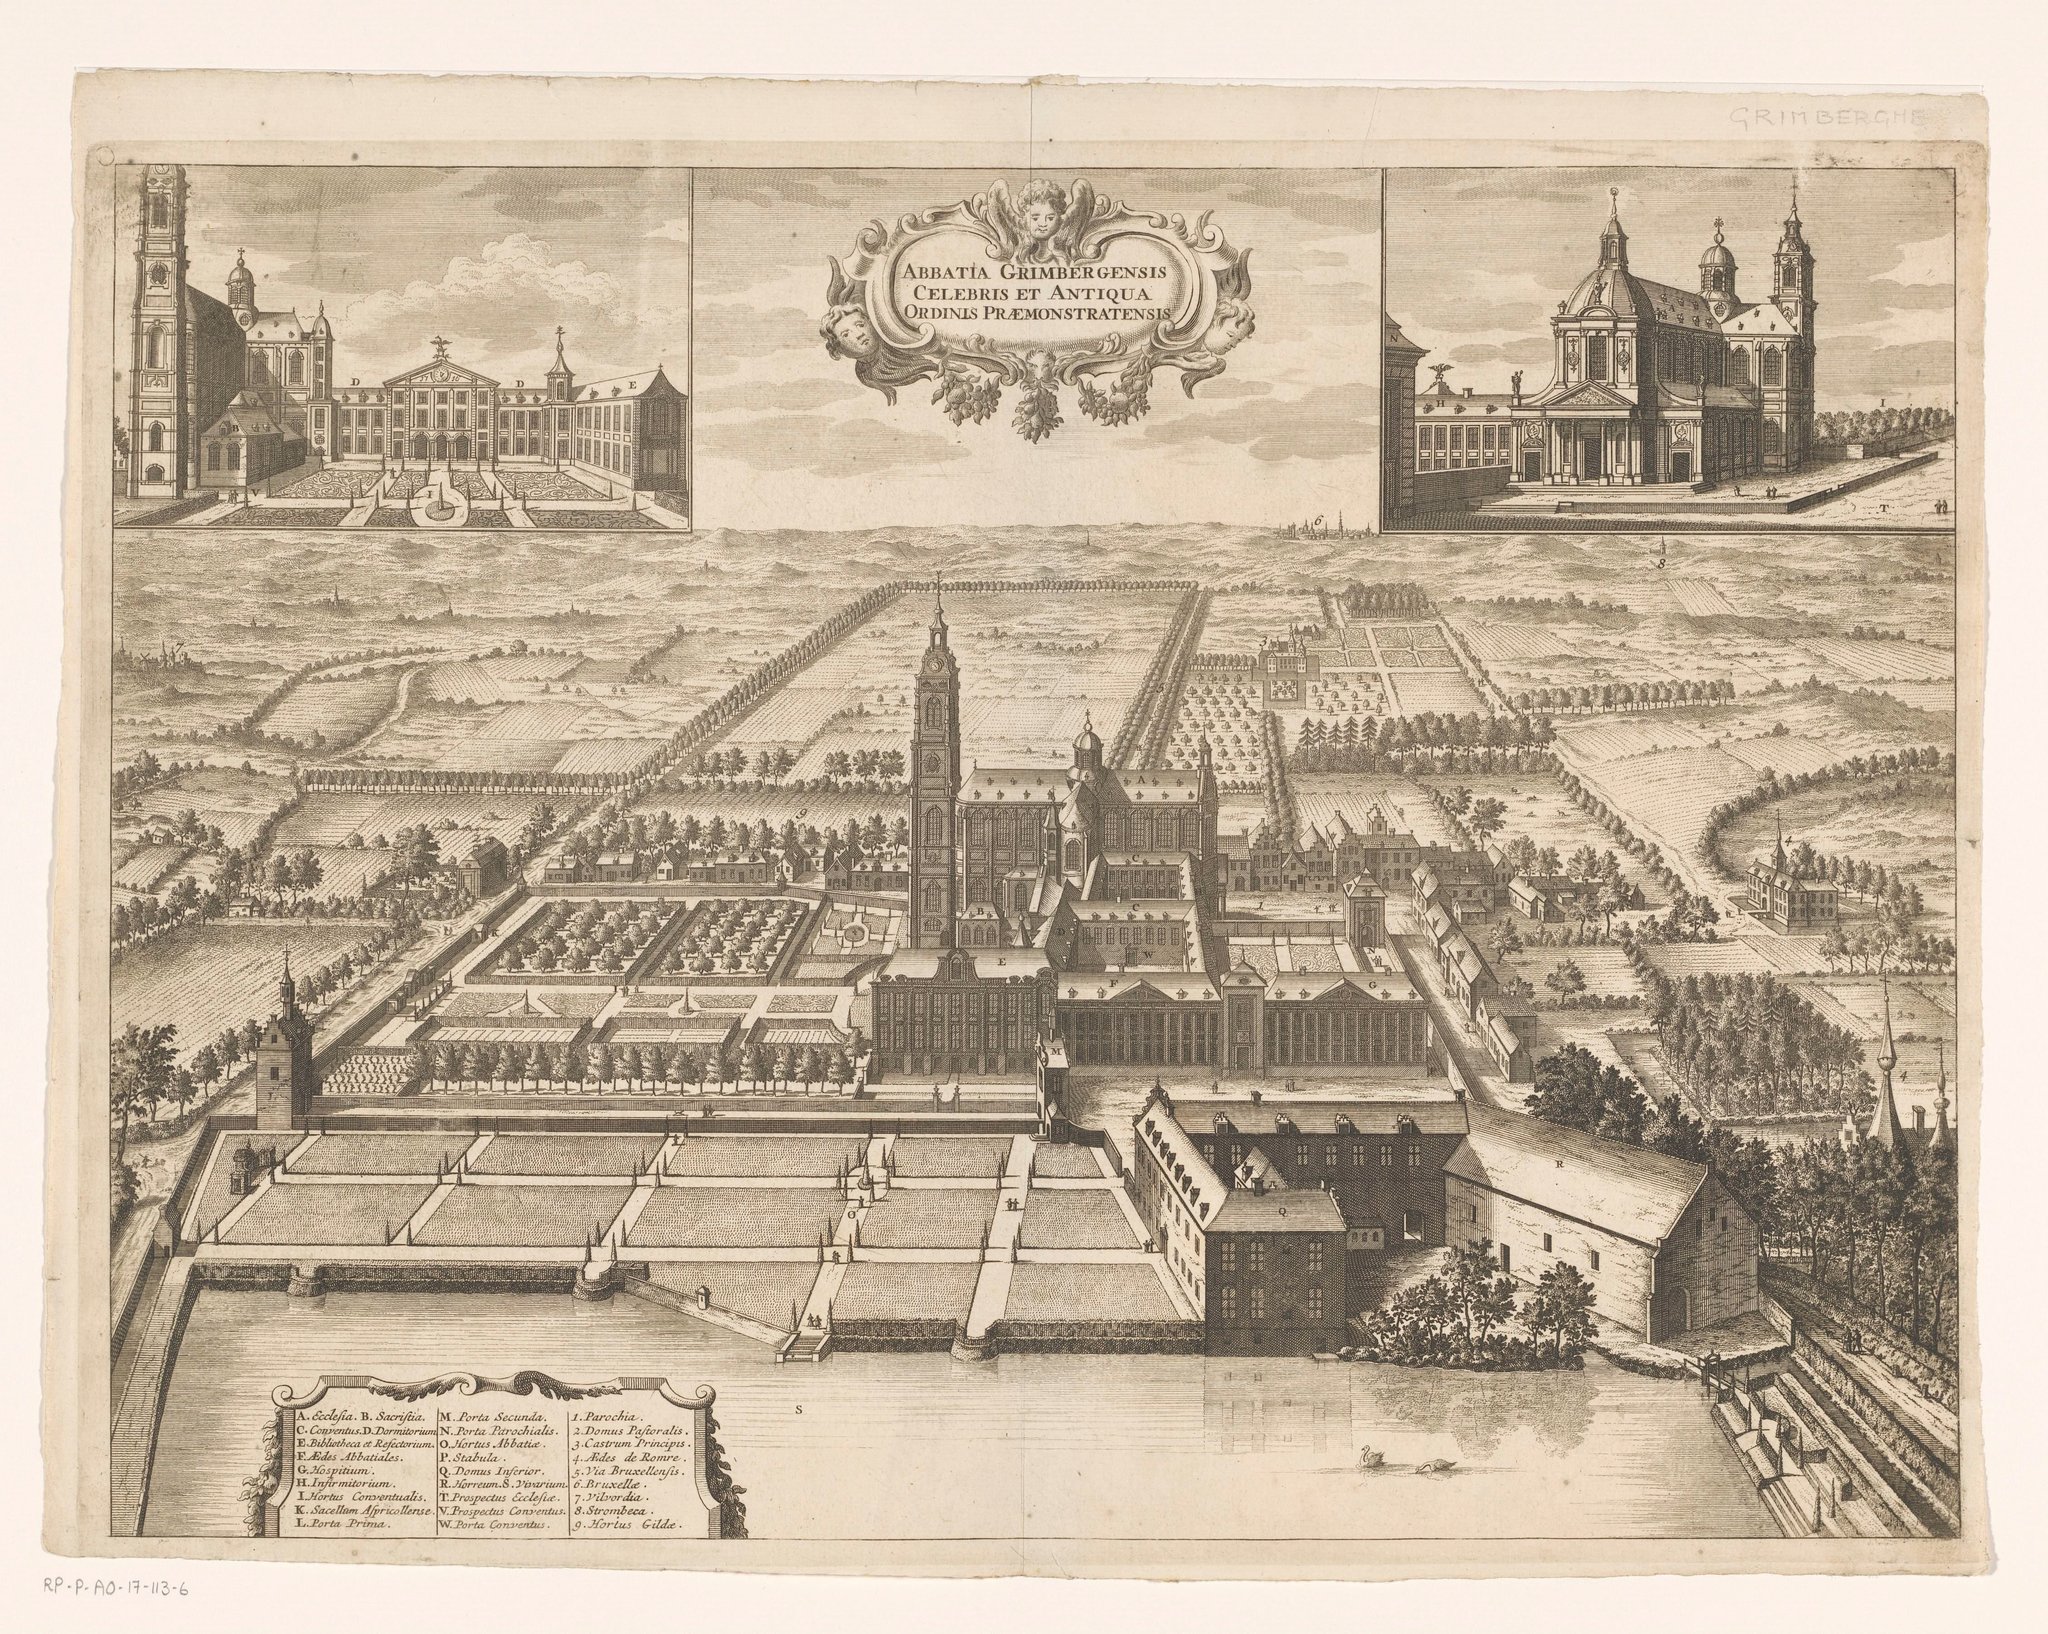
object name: book illustration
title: Gezicht op de Abdij van Grimbergen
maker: Anonymous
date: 1726-1734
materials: paper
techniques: etching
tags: abbey, monastery, convent ~ roman catholic church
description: Prent ook gebruikt in: Sanderus, Antonius. Groot kerkelyk toneel des Hertogdoms van Brabant (...). Den Haag: Christiaan van Lom, 1727. En in: Sanderus, Antonius. Antonii Sanderi presbyteri Chorographia sacra Brabantiæ. 3 delen. Den Haag: Christiaan van Lom, 1726-1727, dl. 1 (1726). En in: Sanderus, Antonius. Le grand theatre sacré du duché de Brabant (...). 4 delen. Den Haag: Gerard Block, 1729-1734.